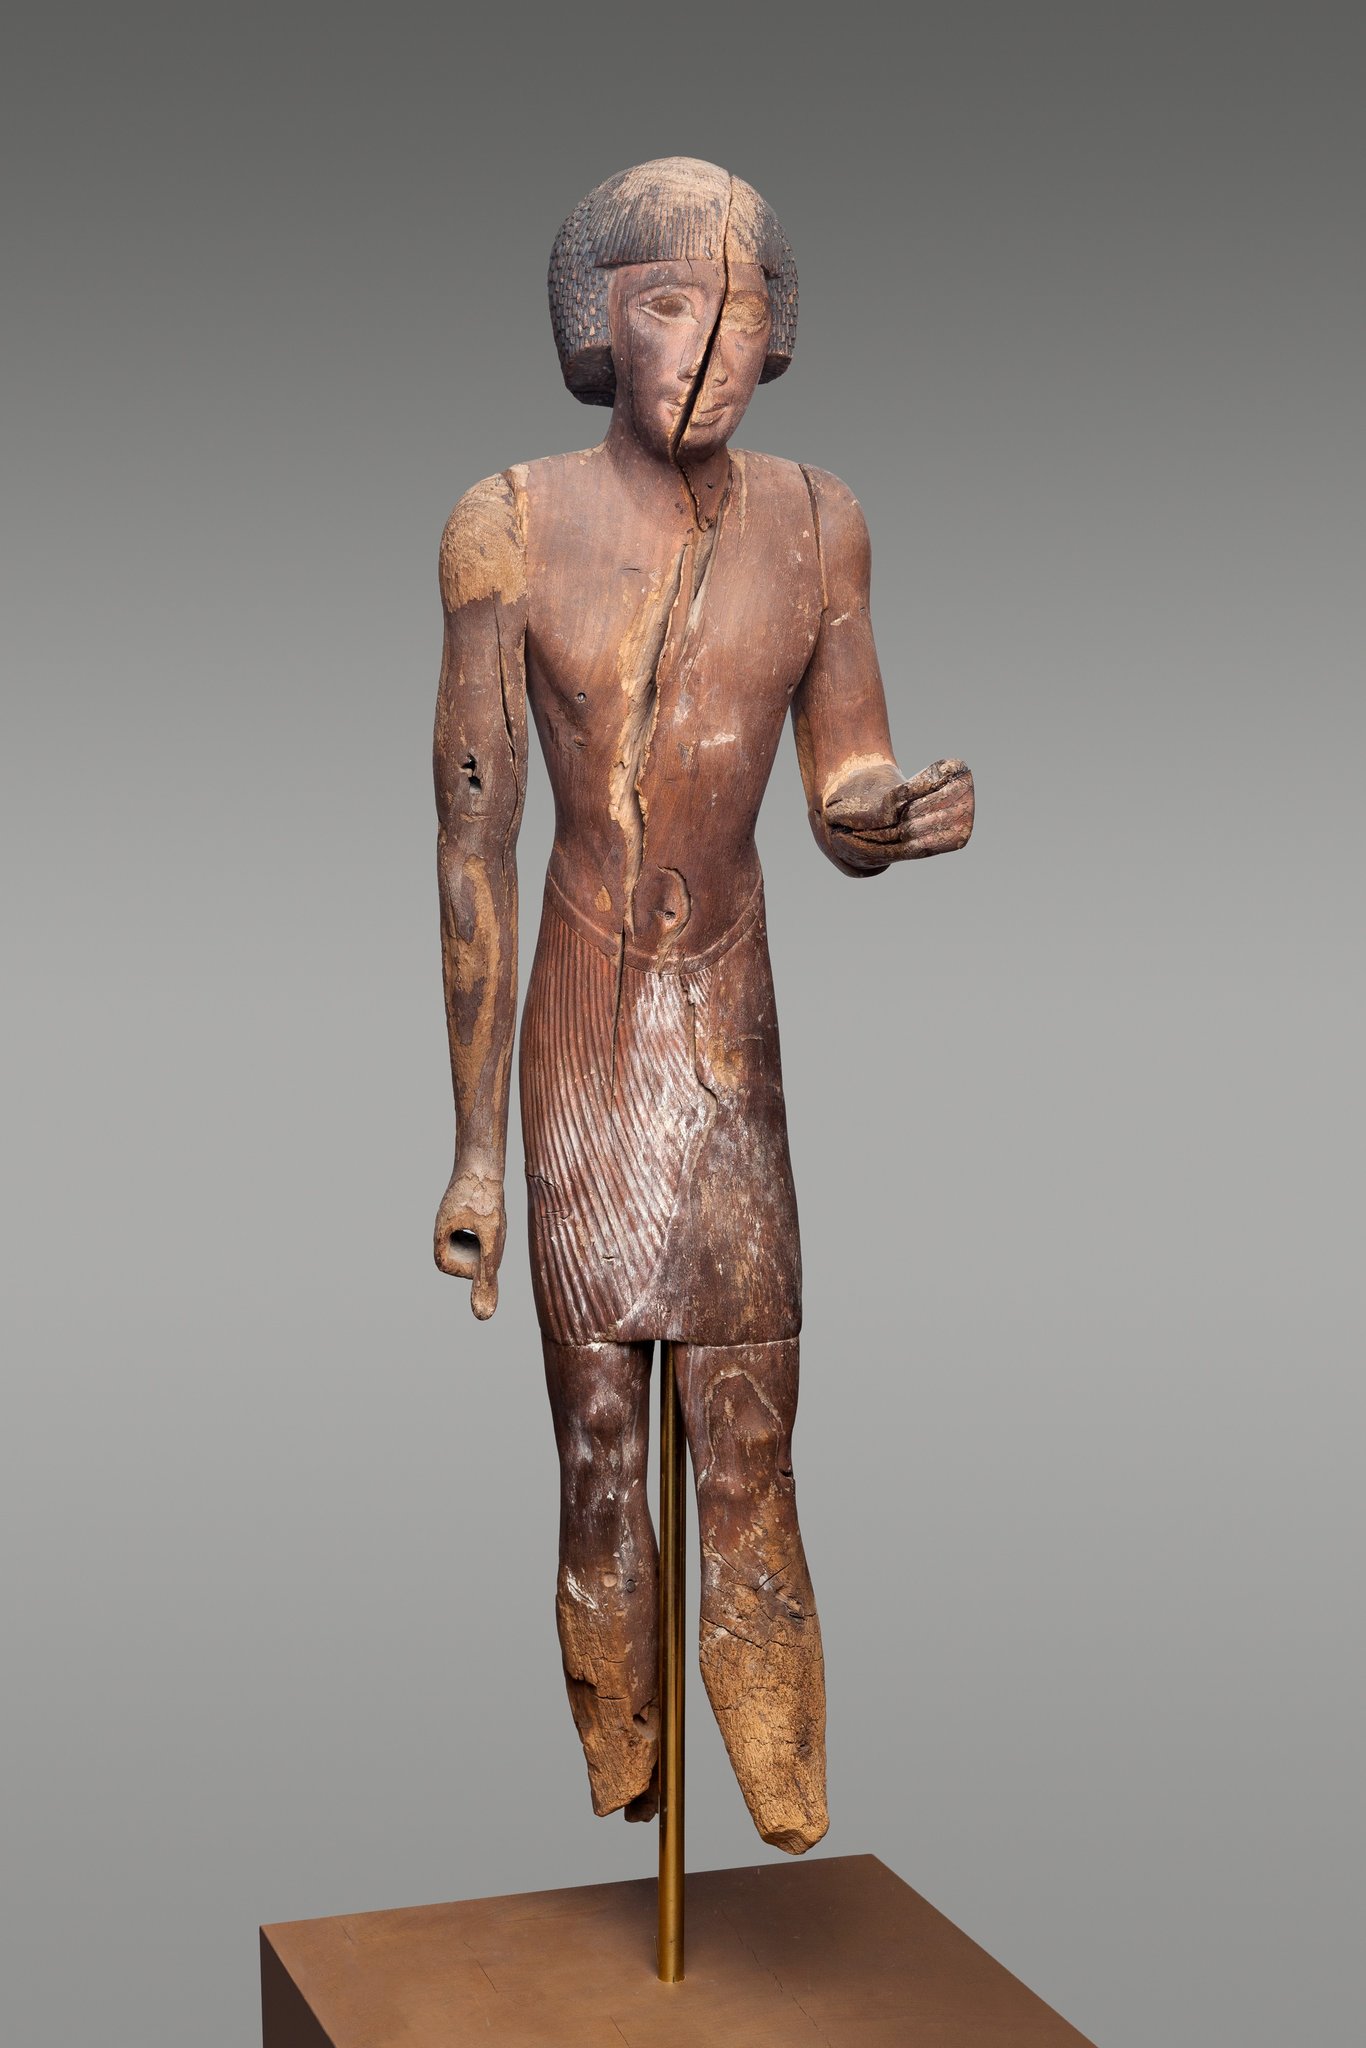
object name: statue, courtier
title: Statue of a courtier Ihy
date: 2200-2100 BCE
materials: wood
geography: egypt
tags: men